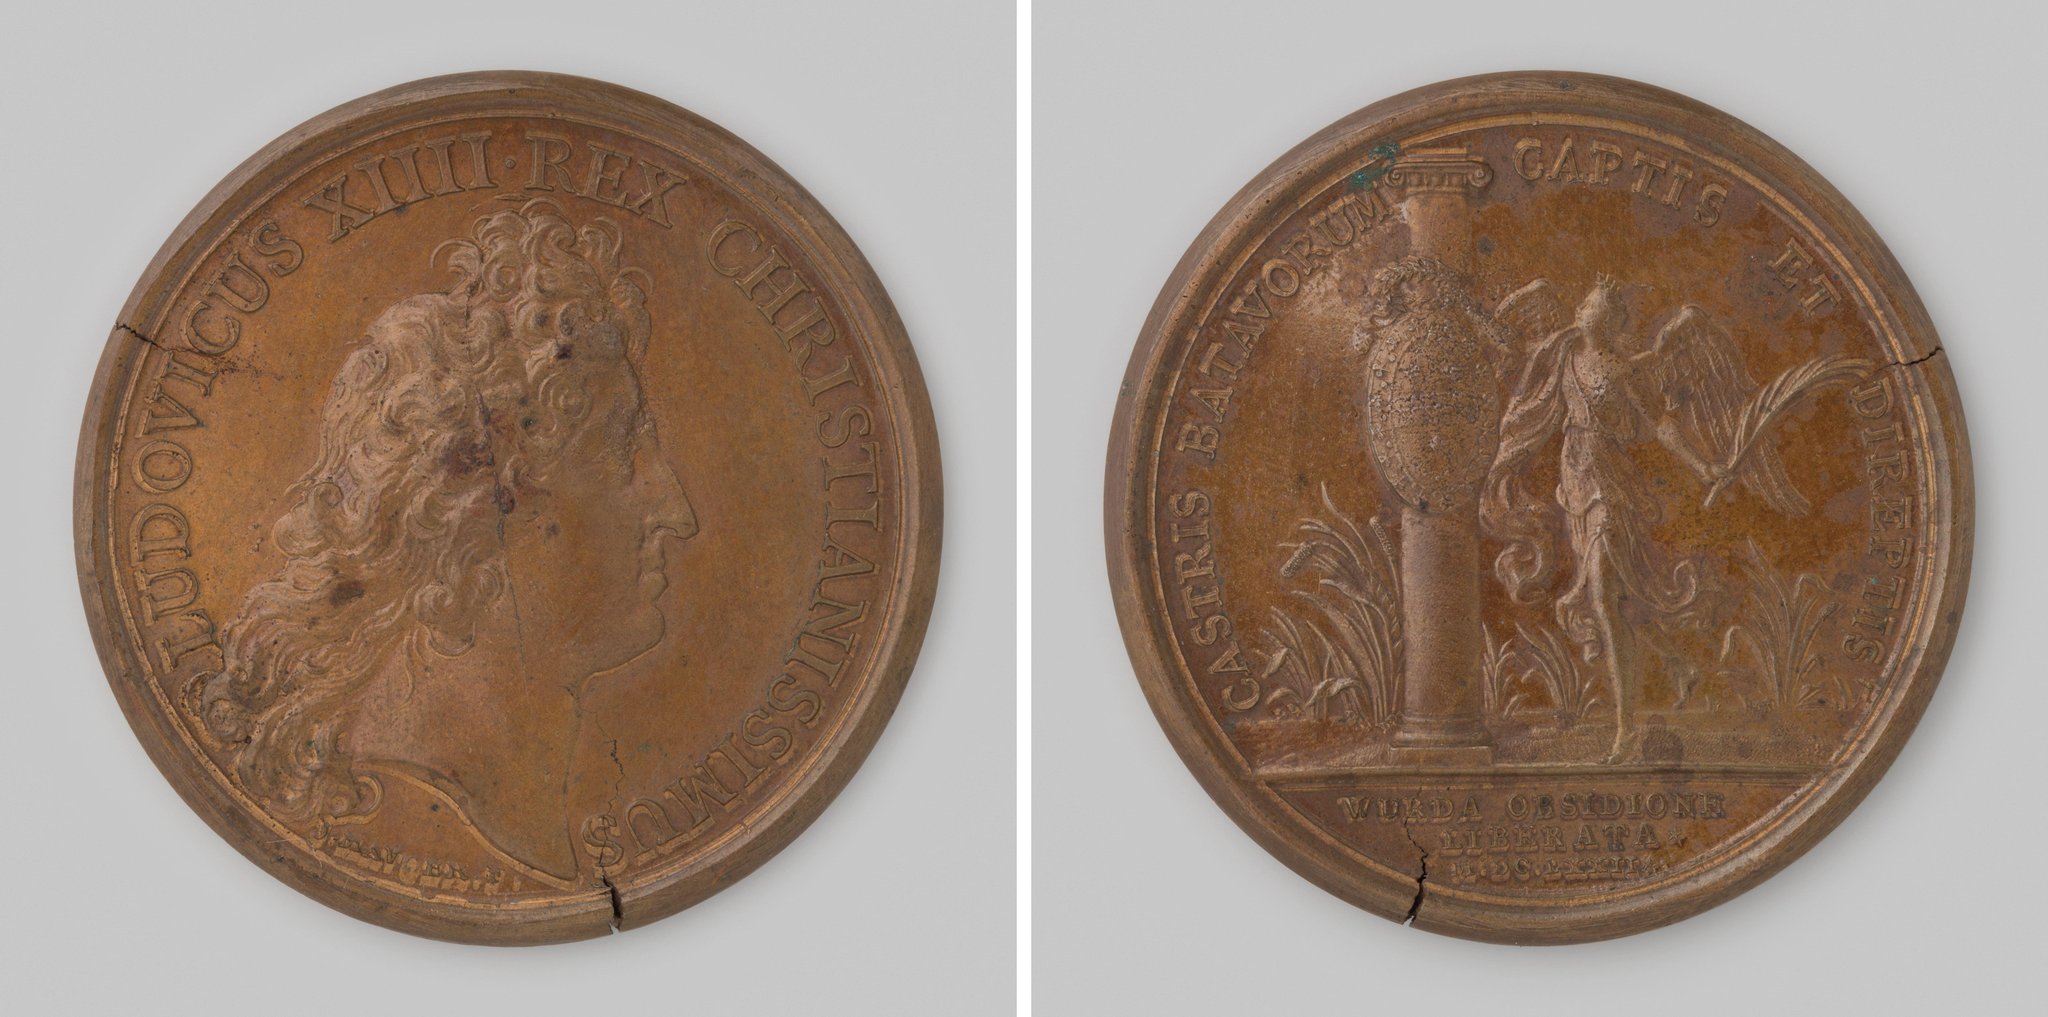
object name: history medal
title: Inname van Woerden door de Fransen 1672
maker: jean mauger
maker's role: medailleur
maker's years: 1648-1722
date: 1672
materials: copper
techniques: striking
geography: paris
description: Koperen penning, op de voorzijde het portret van Lodewijk XIIII met hoge pruik, met omschrtift, op de keerzijde Victoria die een Woerdens wapenschil bekranst dat aan een zuil hangt, met omschrift en afsnedetekst.